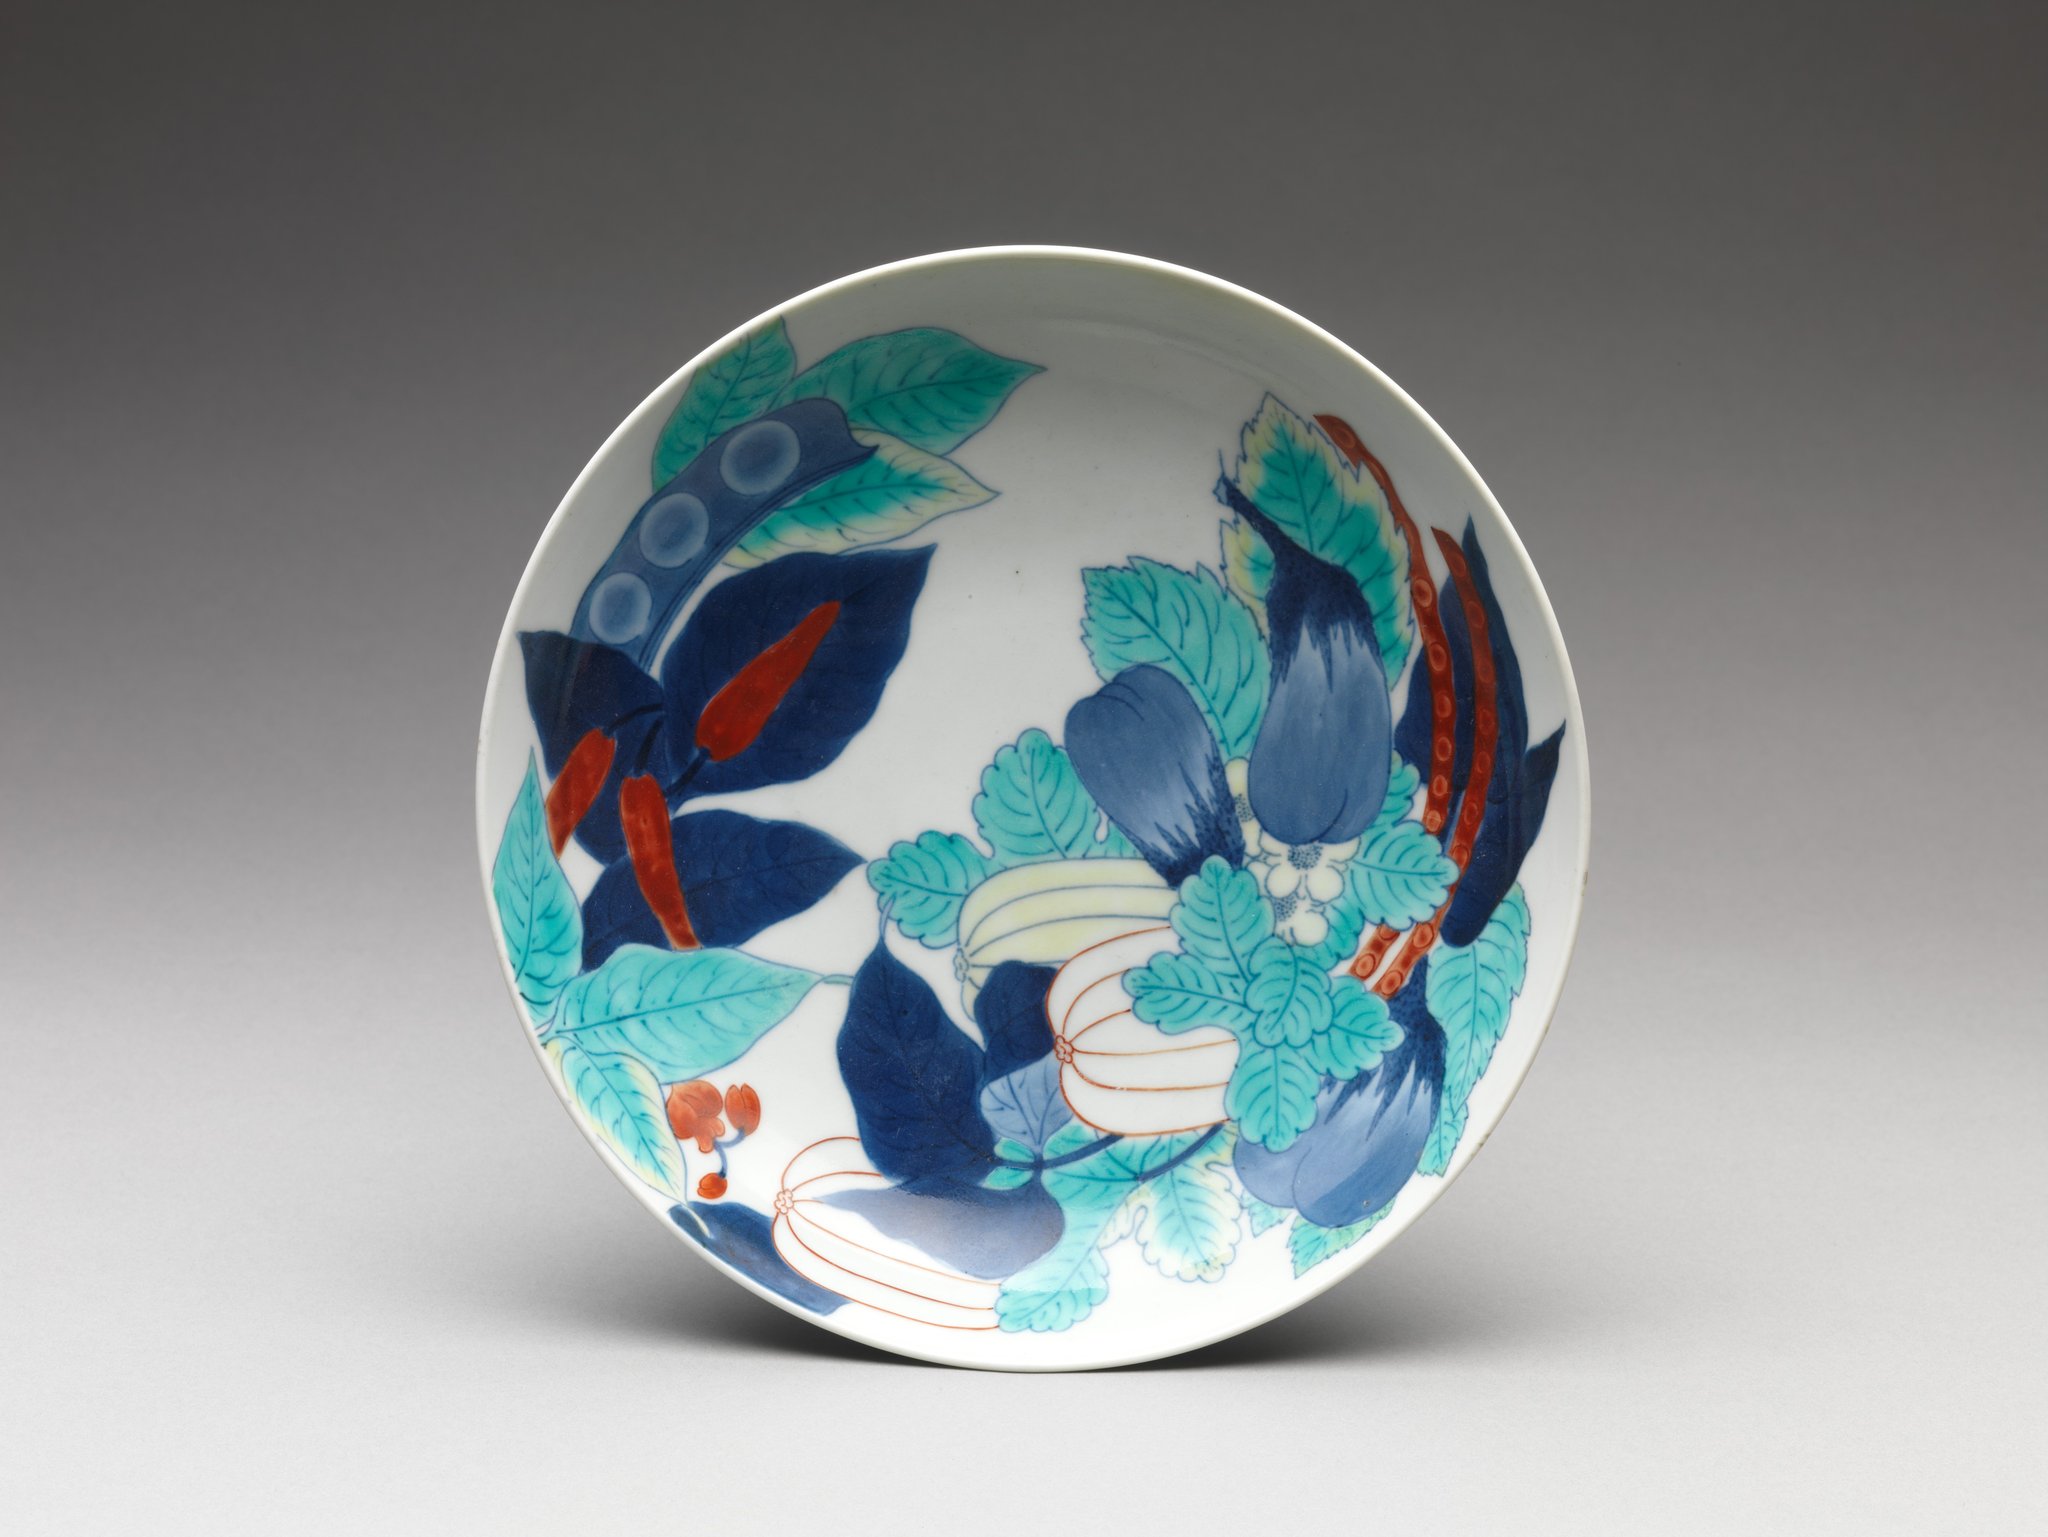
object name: dish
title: Dish with Design of Beans, Squash, and Eggplant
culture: japanese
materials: enamel, porcelain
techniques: overglaze, underglaze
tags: vegetables,eggplants